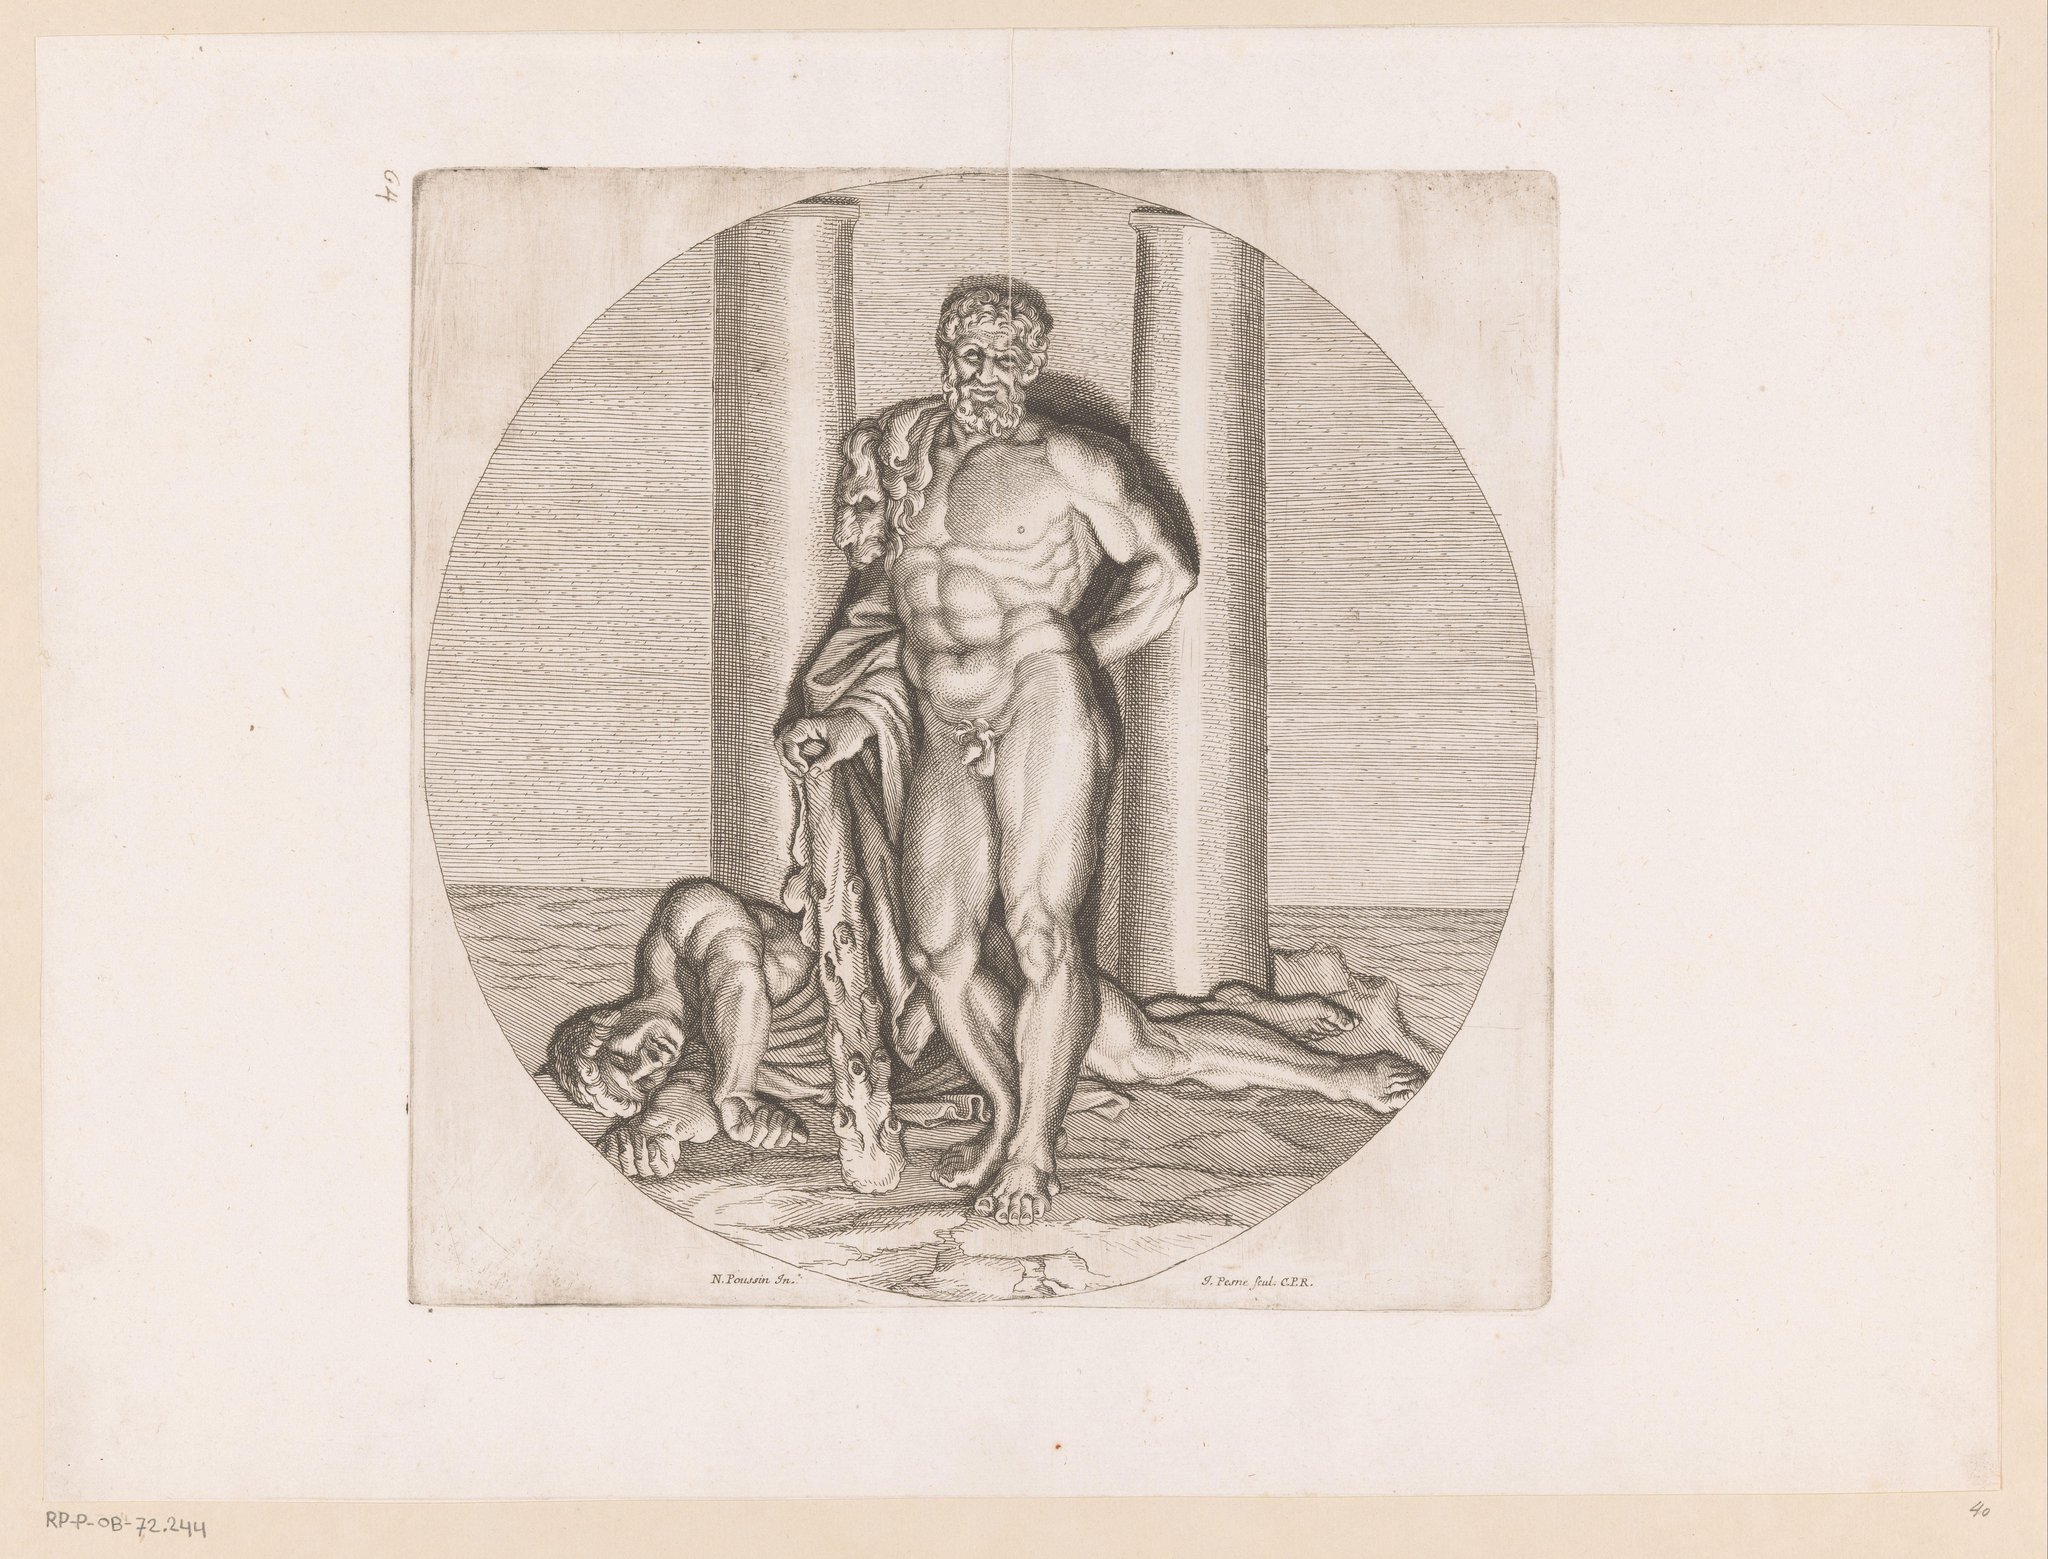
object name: print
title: Herculis Labores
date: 1678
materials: paper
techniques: engraving, etching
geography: france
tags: the giant antaeus is lifted in the air and crushed to death by hercules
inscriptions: collector's mark: Lugt 240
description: Prent maakt deel uit van een ongenummerde serie van negentien prenten.